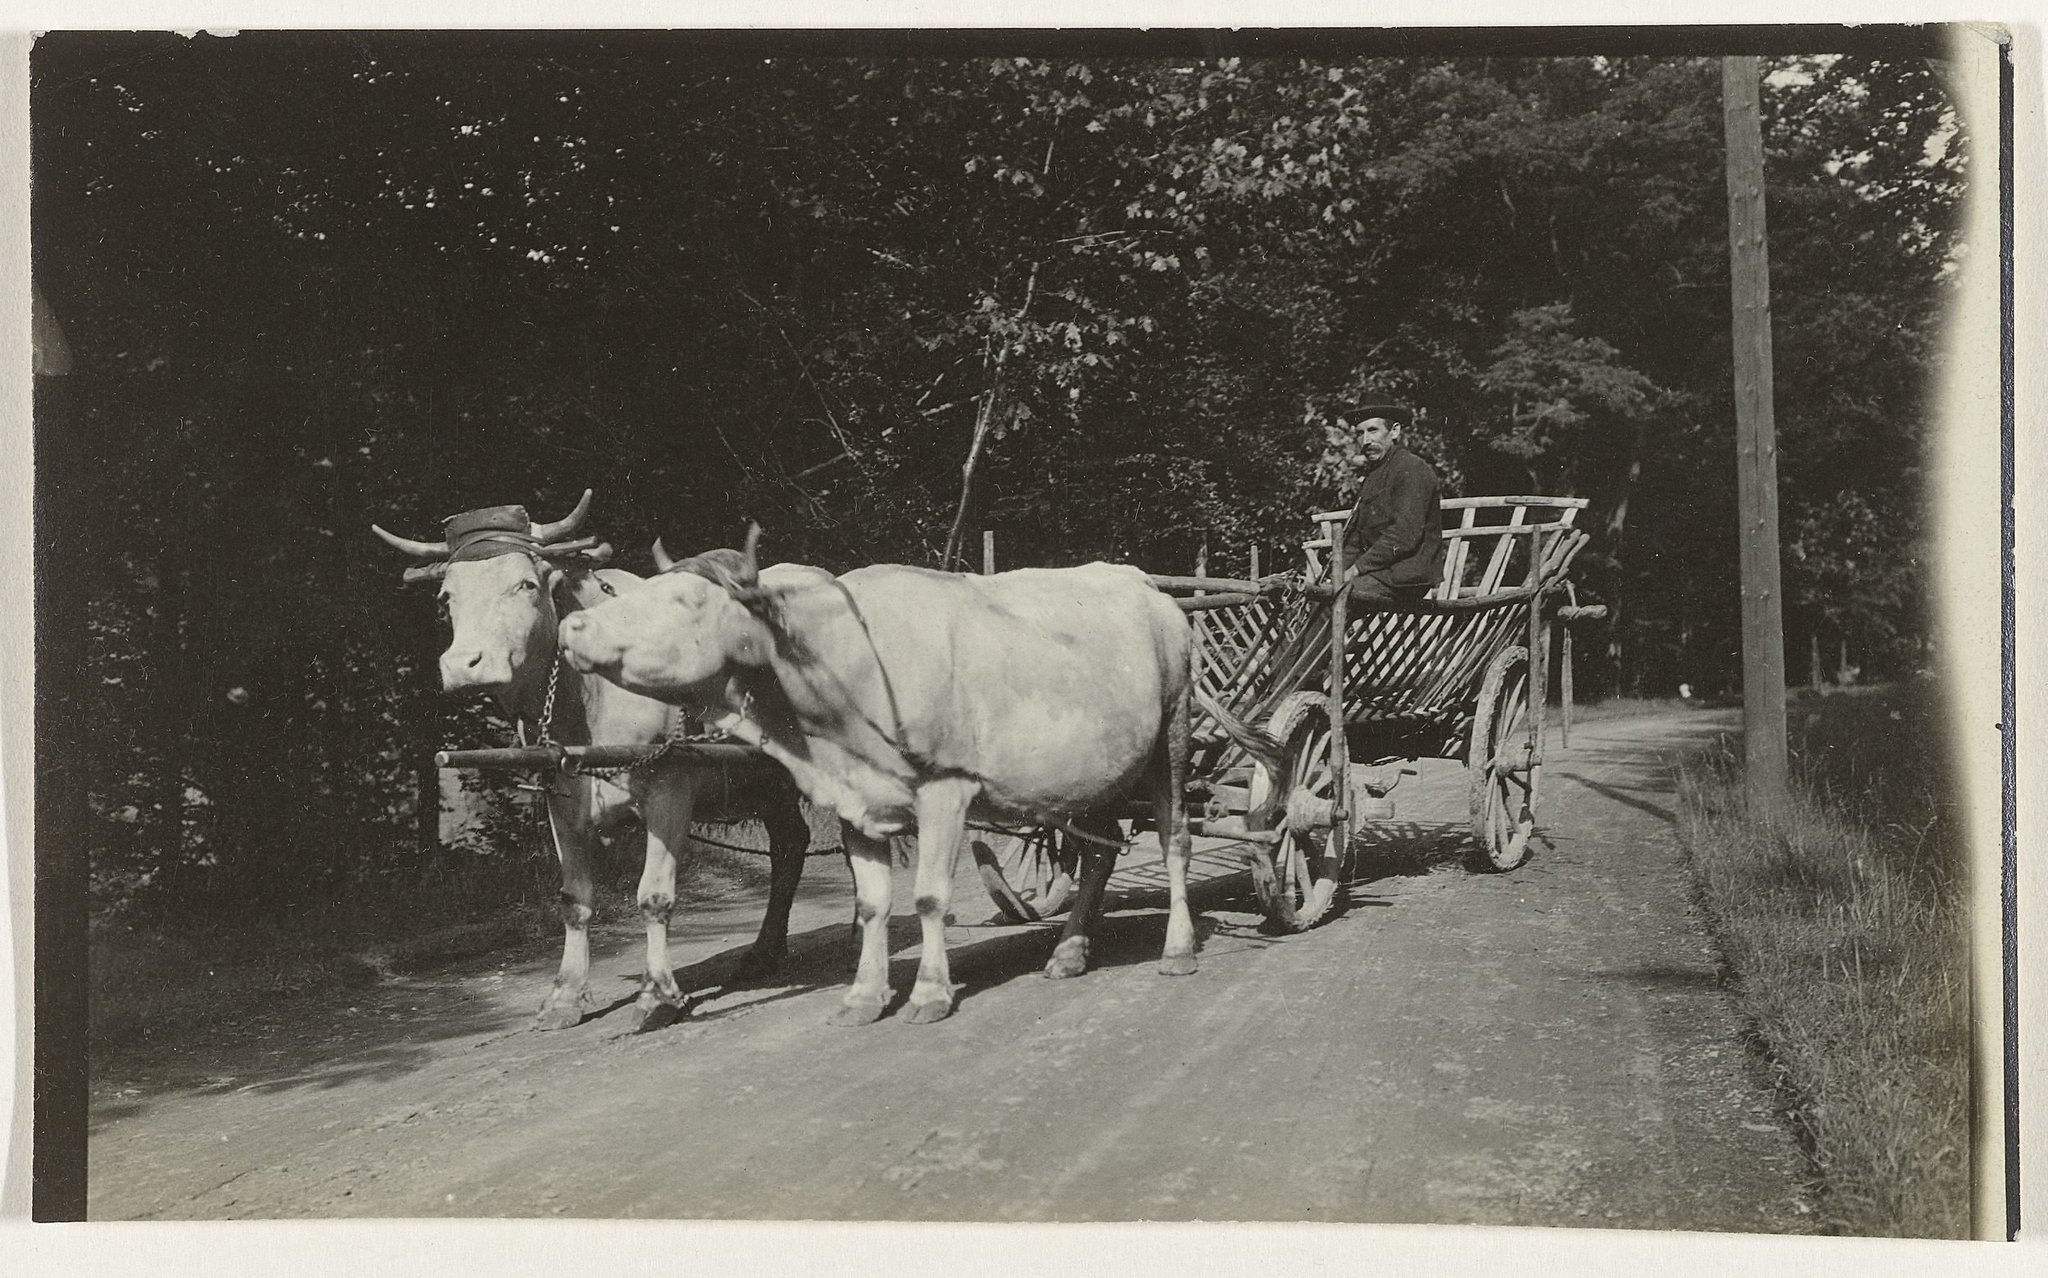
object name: photograph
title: Kar met twee ossen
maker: Anonymous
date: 1900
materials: paper, photographic support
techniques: gelatin silver print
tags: (farm) wagon, freight wagon, cart (+ propulsion of vehicle, ship, etc. by animals), ox